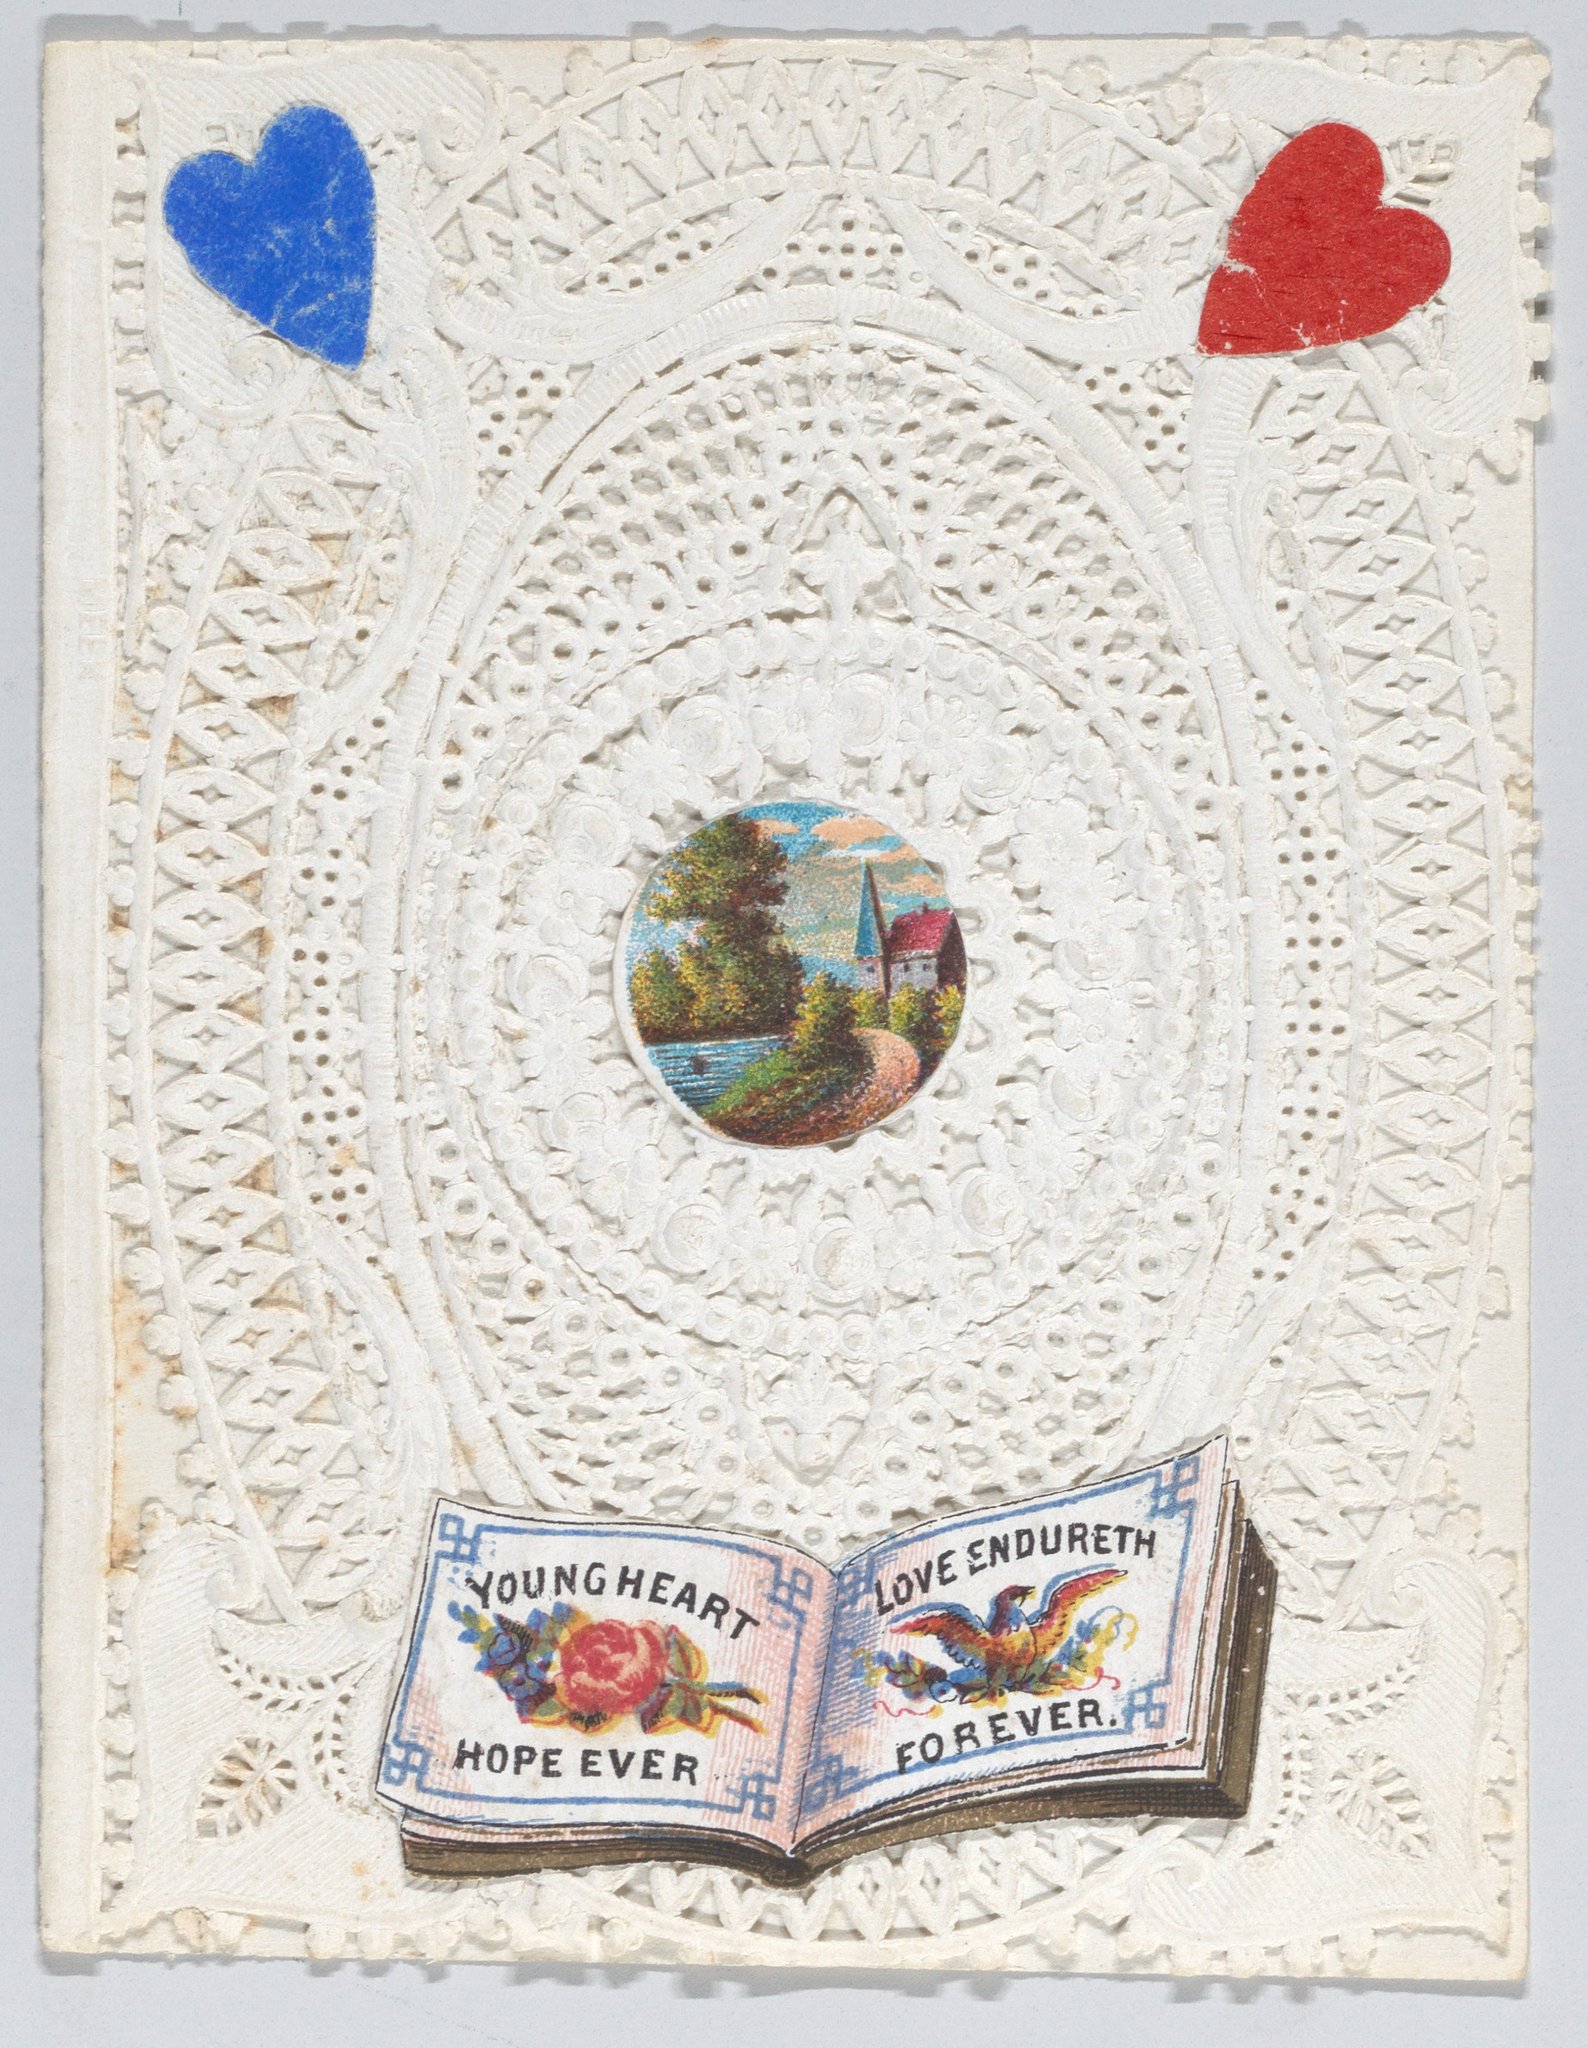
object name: valentine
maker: Anonymous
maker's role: artist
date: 1847-1870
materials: lace, paper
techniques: chromolithography, embossing, open work